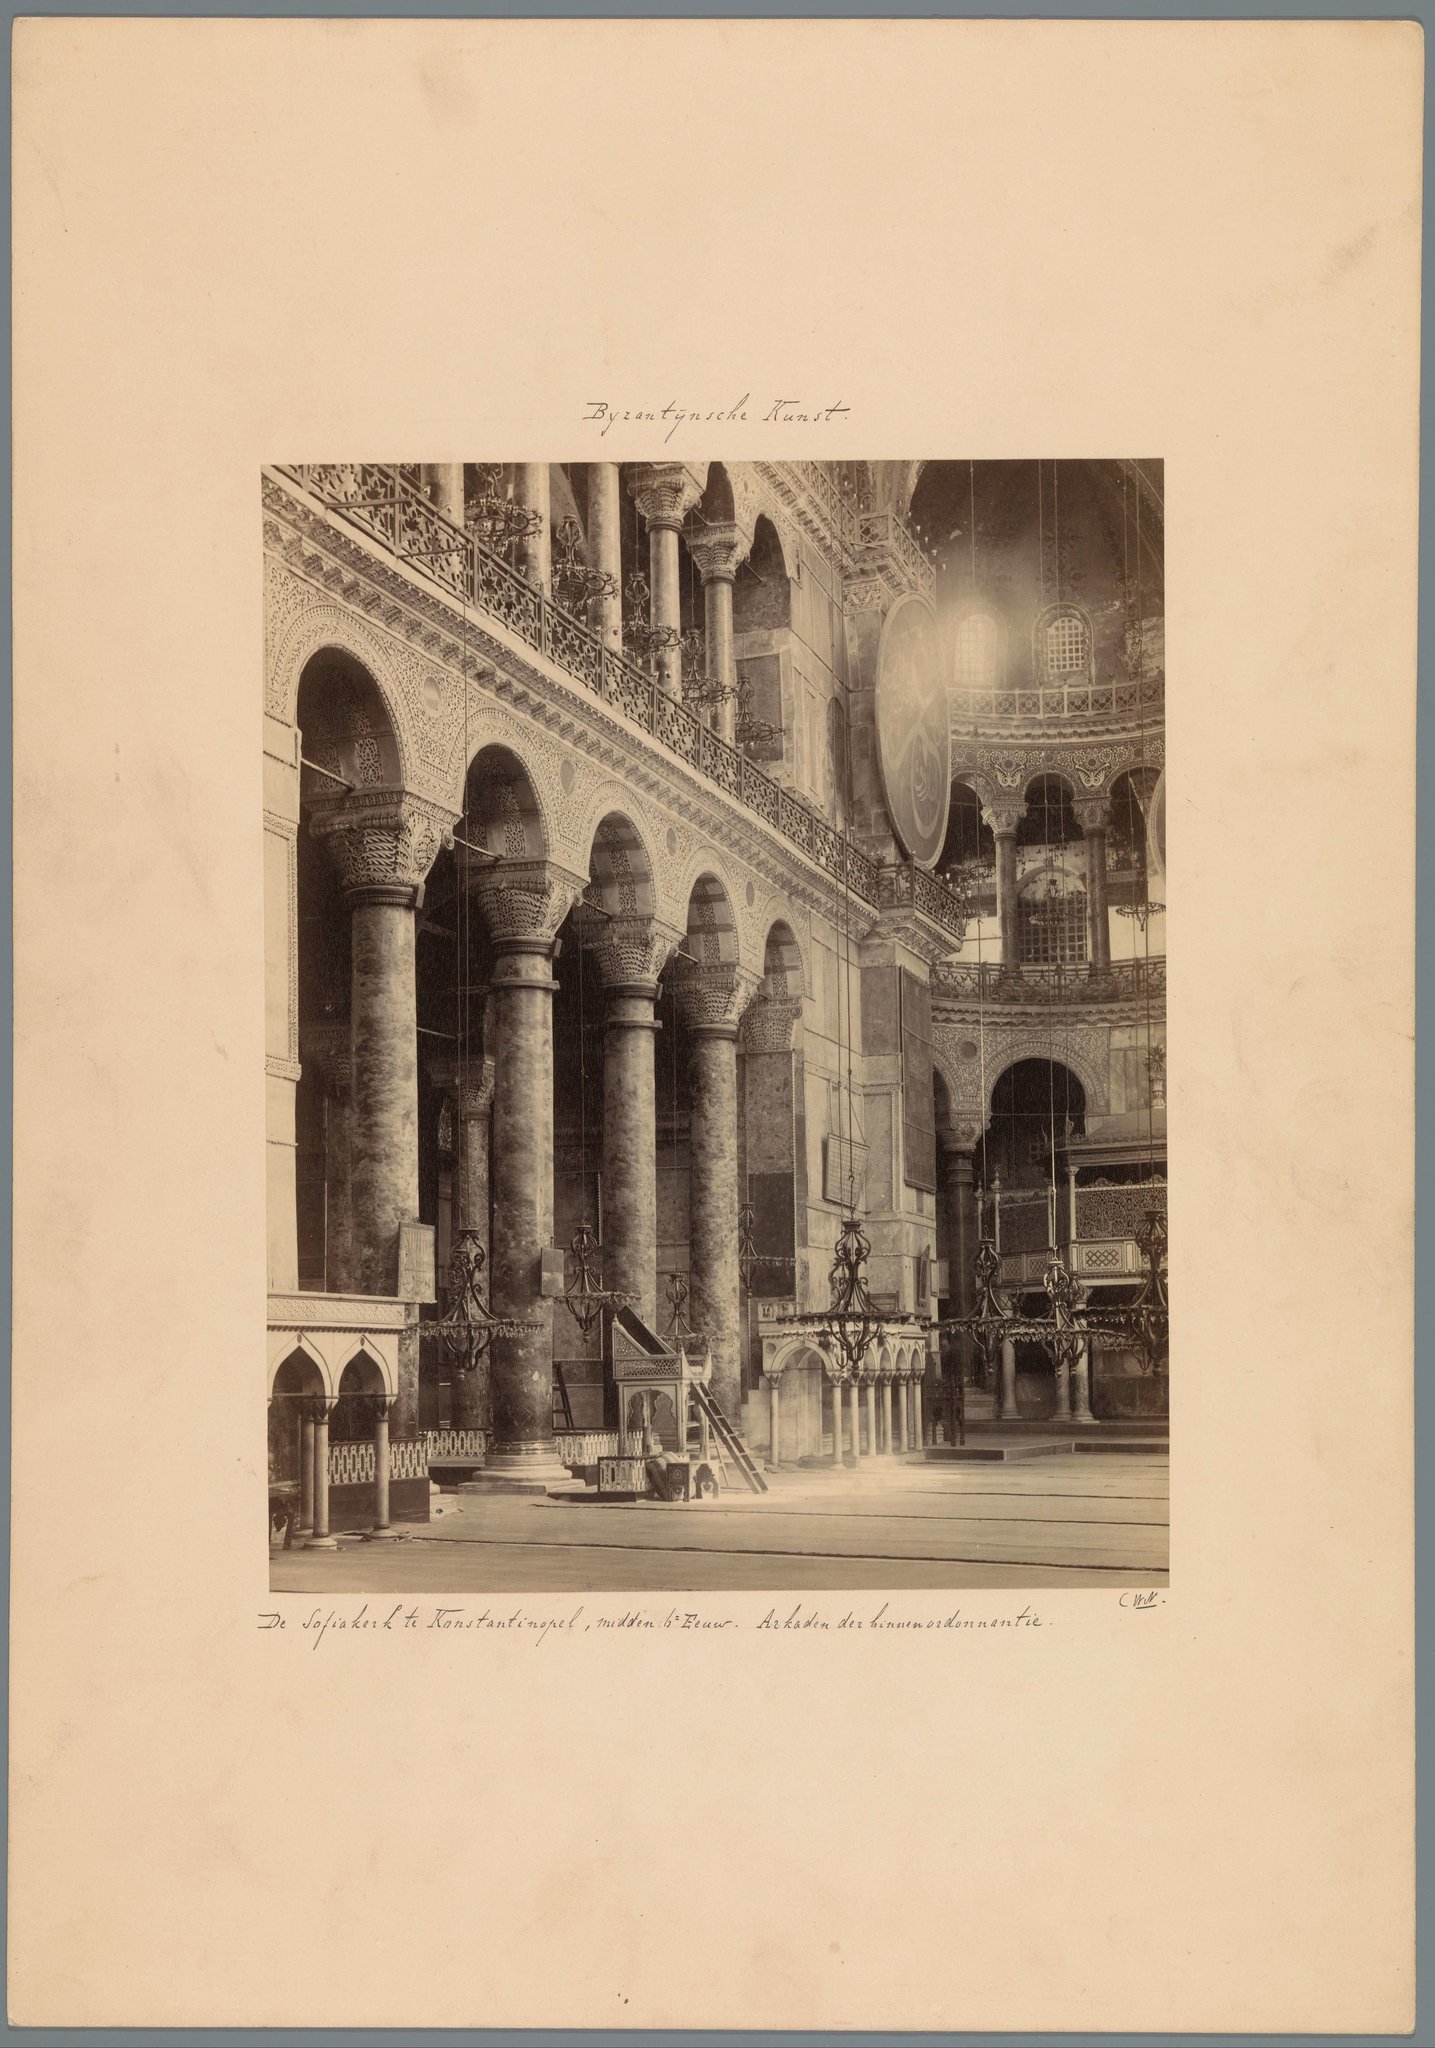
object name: photograph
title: Deel van het interieur van de Hagia Sophia te Istanbul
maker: Anonymous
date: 1875-1900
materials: cardboard, photographic support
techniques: albumen print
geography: hagia sophia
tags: pulpit, ambo, chancel, interior ~ representation of a building, arcade ~ architecture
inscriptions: collector's mark: ‘INSTITUUT VOOR KUNST- NIJVERHEIDSONDERWIJS GABRIËL METSUSTRAAT No. 16. AMSTERDAM’, inscription: ‘Byzantijnsche Kunst. De Sofiakerk te Konstantinopel, midden 6e Eeuw. Arkaden der binnenordonnentie.’, collector's mark: ‘KUNSTNIJVERHEIDSCHOOL QUELLINUS AMSTERDAM FRANS HALSSTRAAT 14.’, inscription: ‘CWN.’